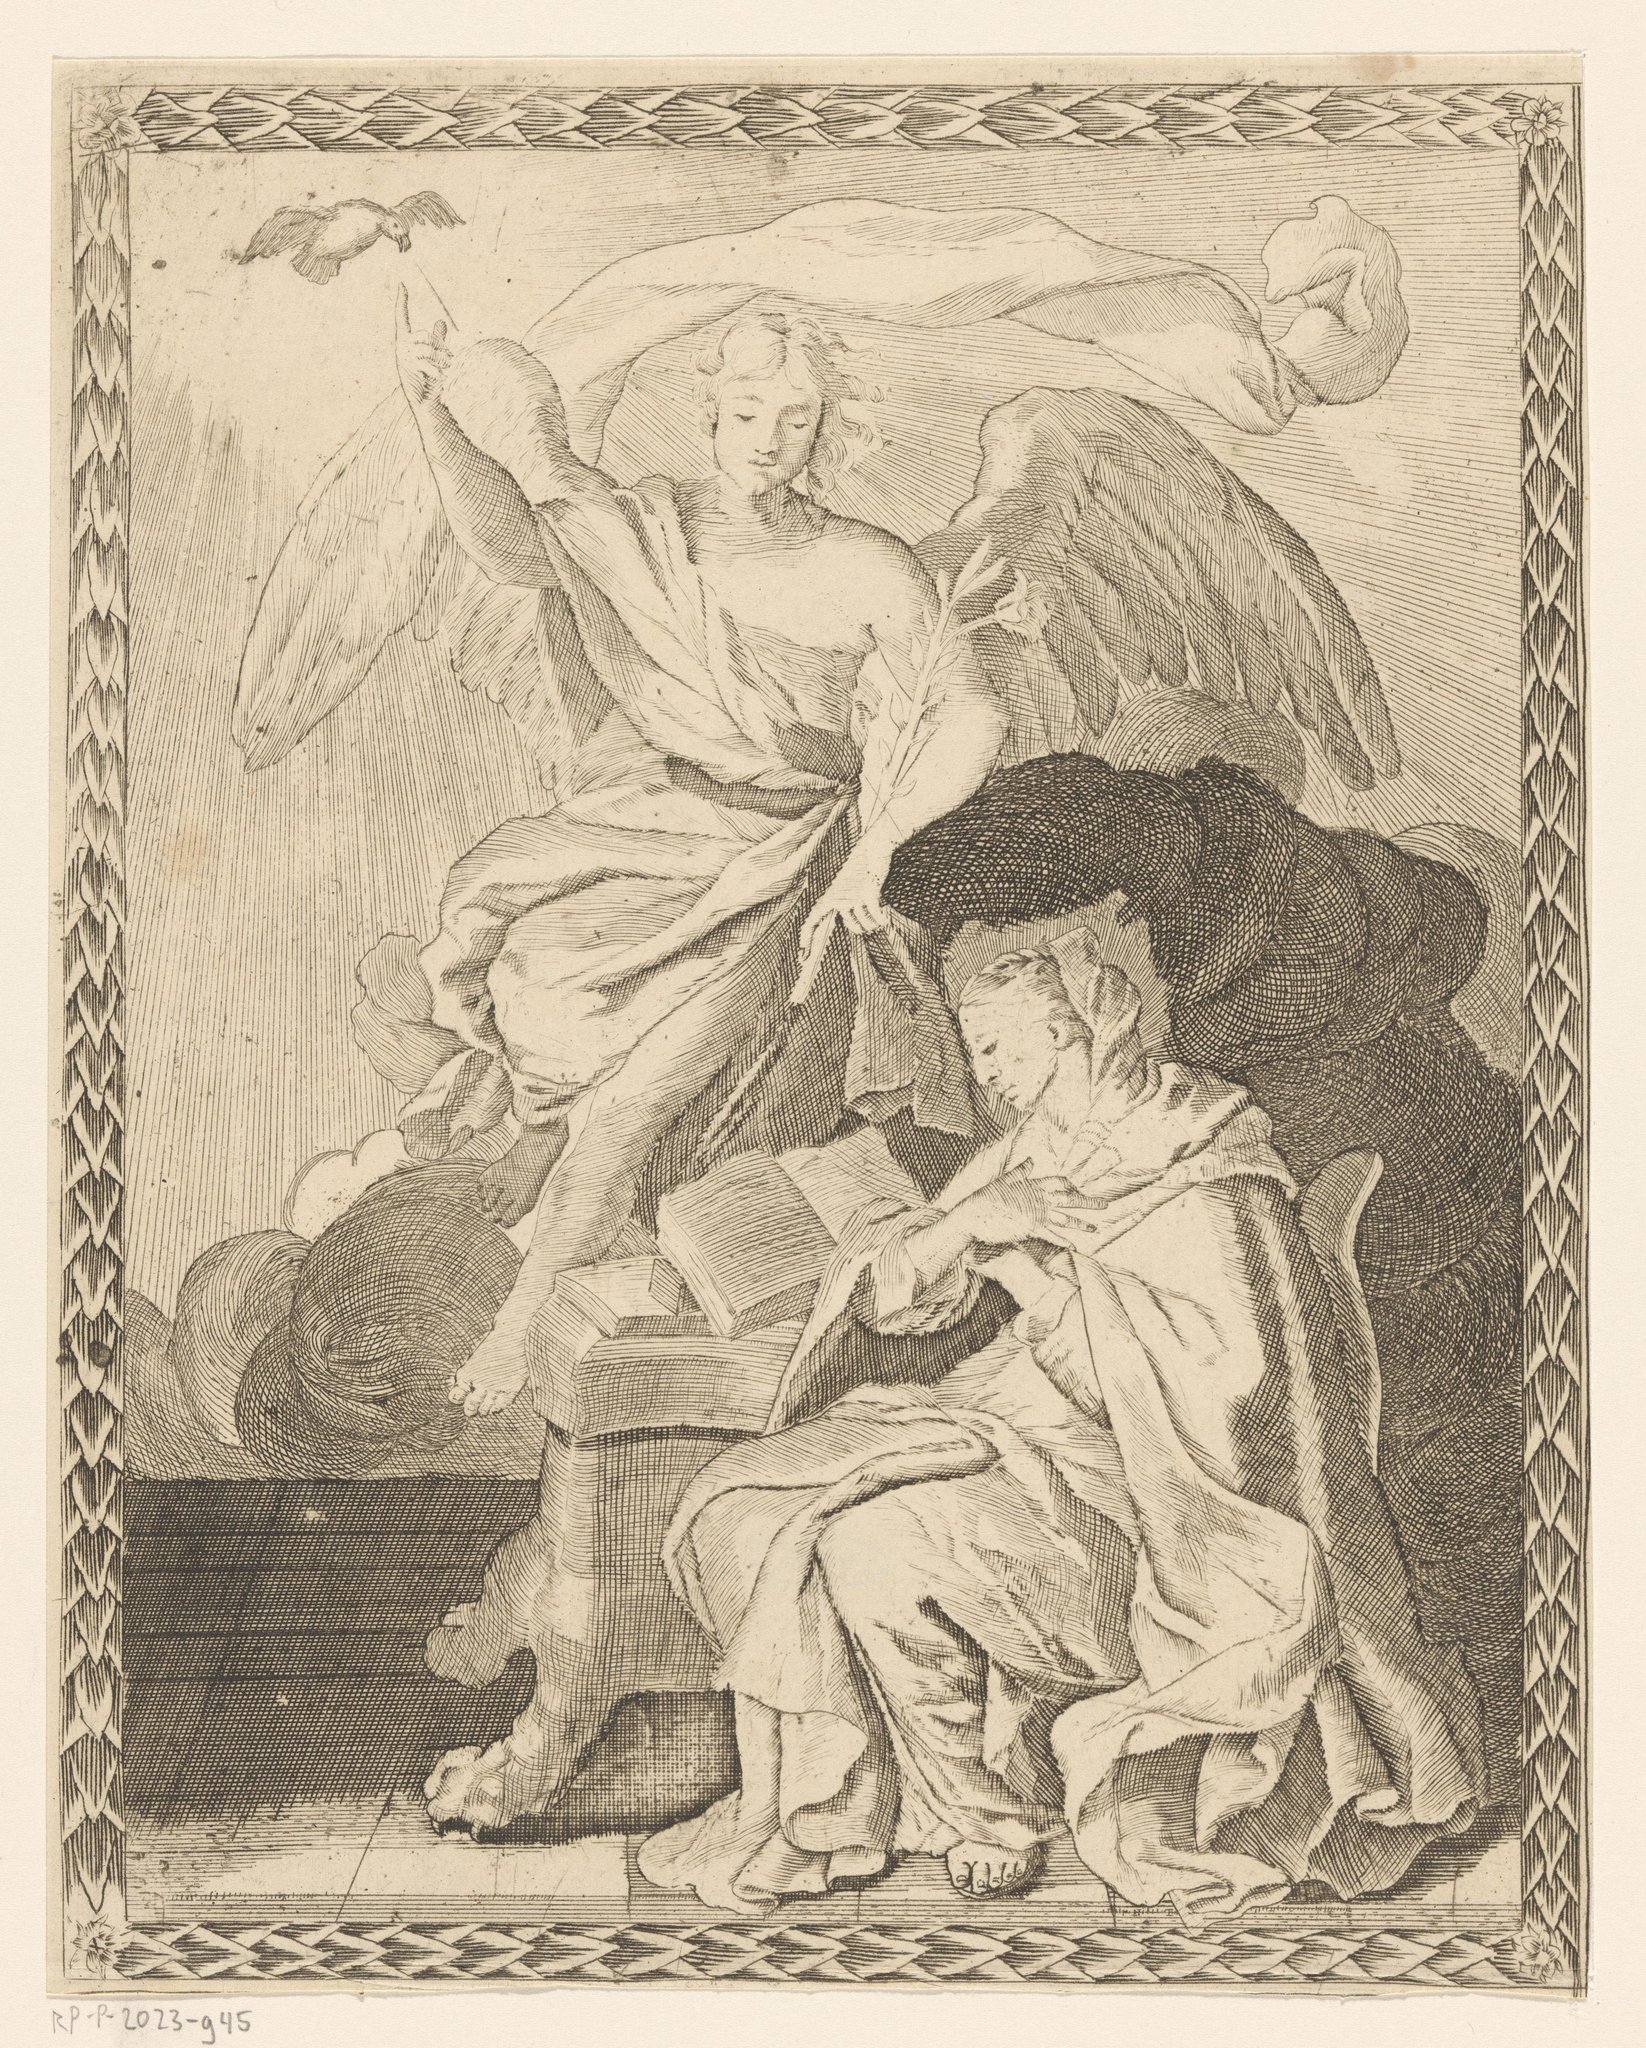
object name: print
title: Engel wijst een lezende man op de Heilige Geest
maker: Anonymous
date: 1700-1799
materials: paper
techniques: engraving, etching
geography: low countries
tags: reading the bible or other religious books, angels, holy ghost represented as a dove (in flames)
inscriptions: collector's mark: Lugt 2228